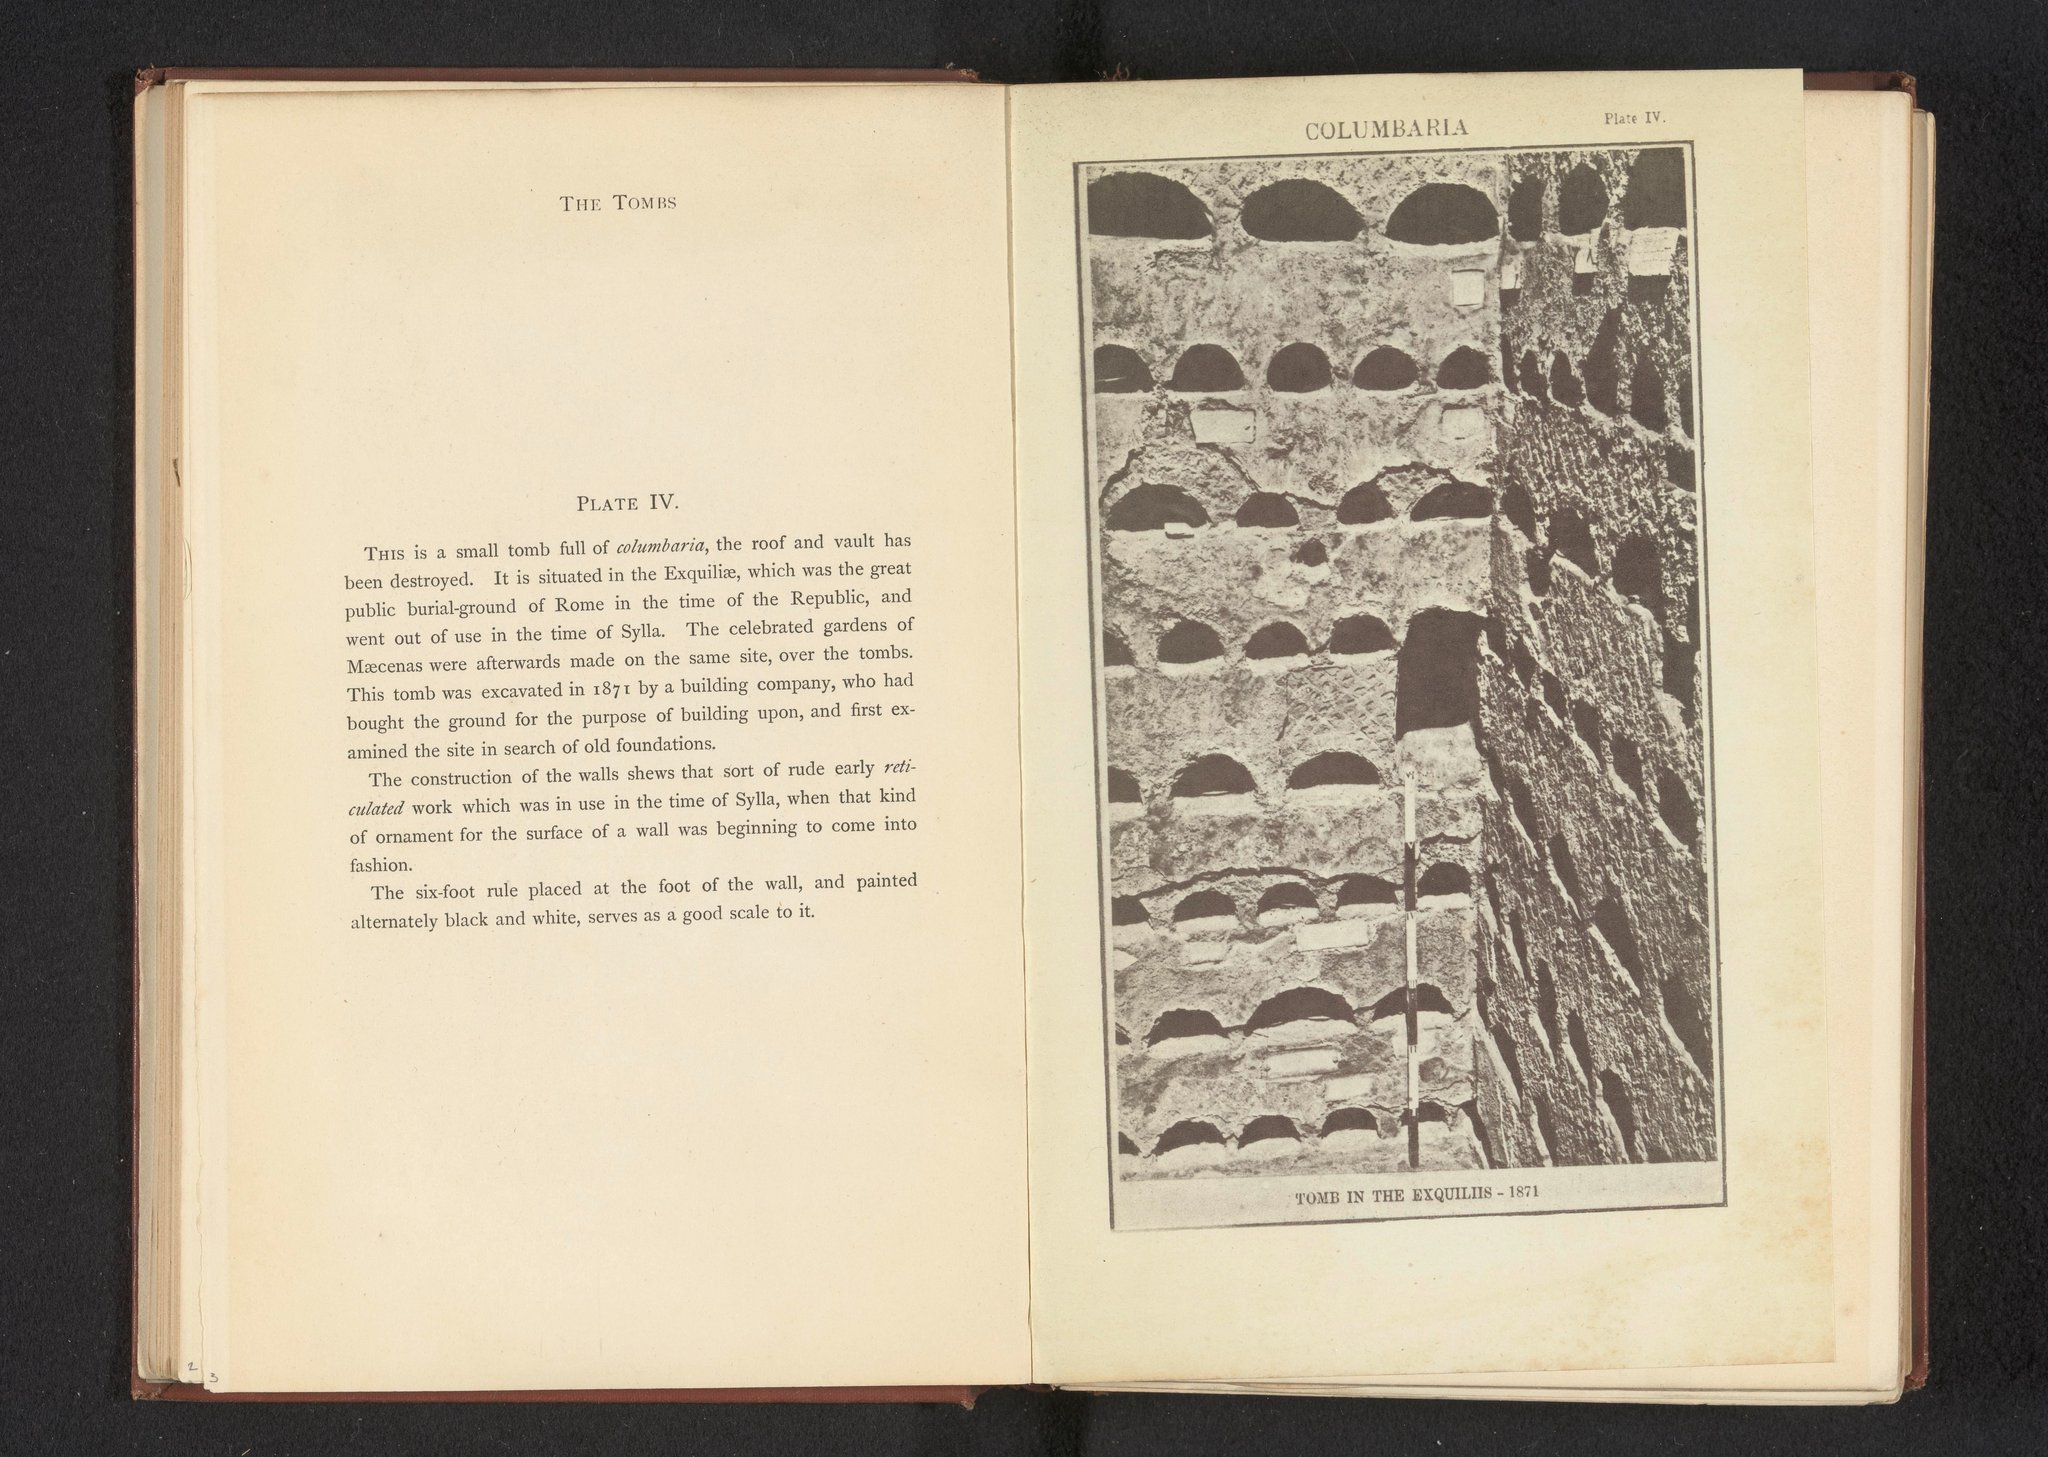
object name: page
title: Muur met nissen in een columbarium in Rome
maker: Anonymous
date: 1871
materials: paper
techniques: photoaquatint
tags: niche-tomb, wall-tomb, urn, rome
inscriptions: number: ‘Plate IV.’